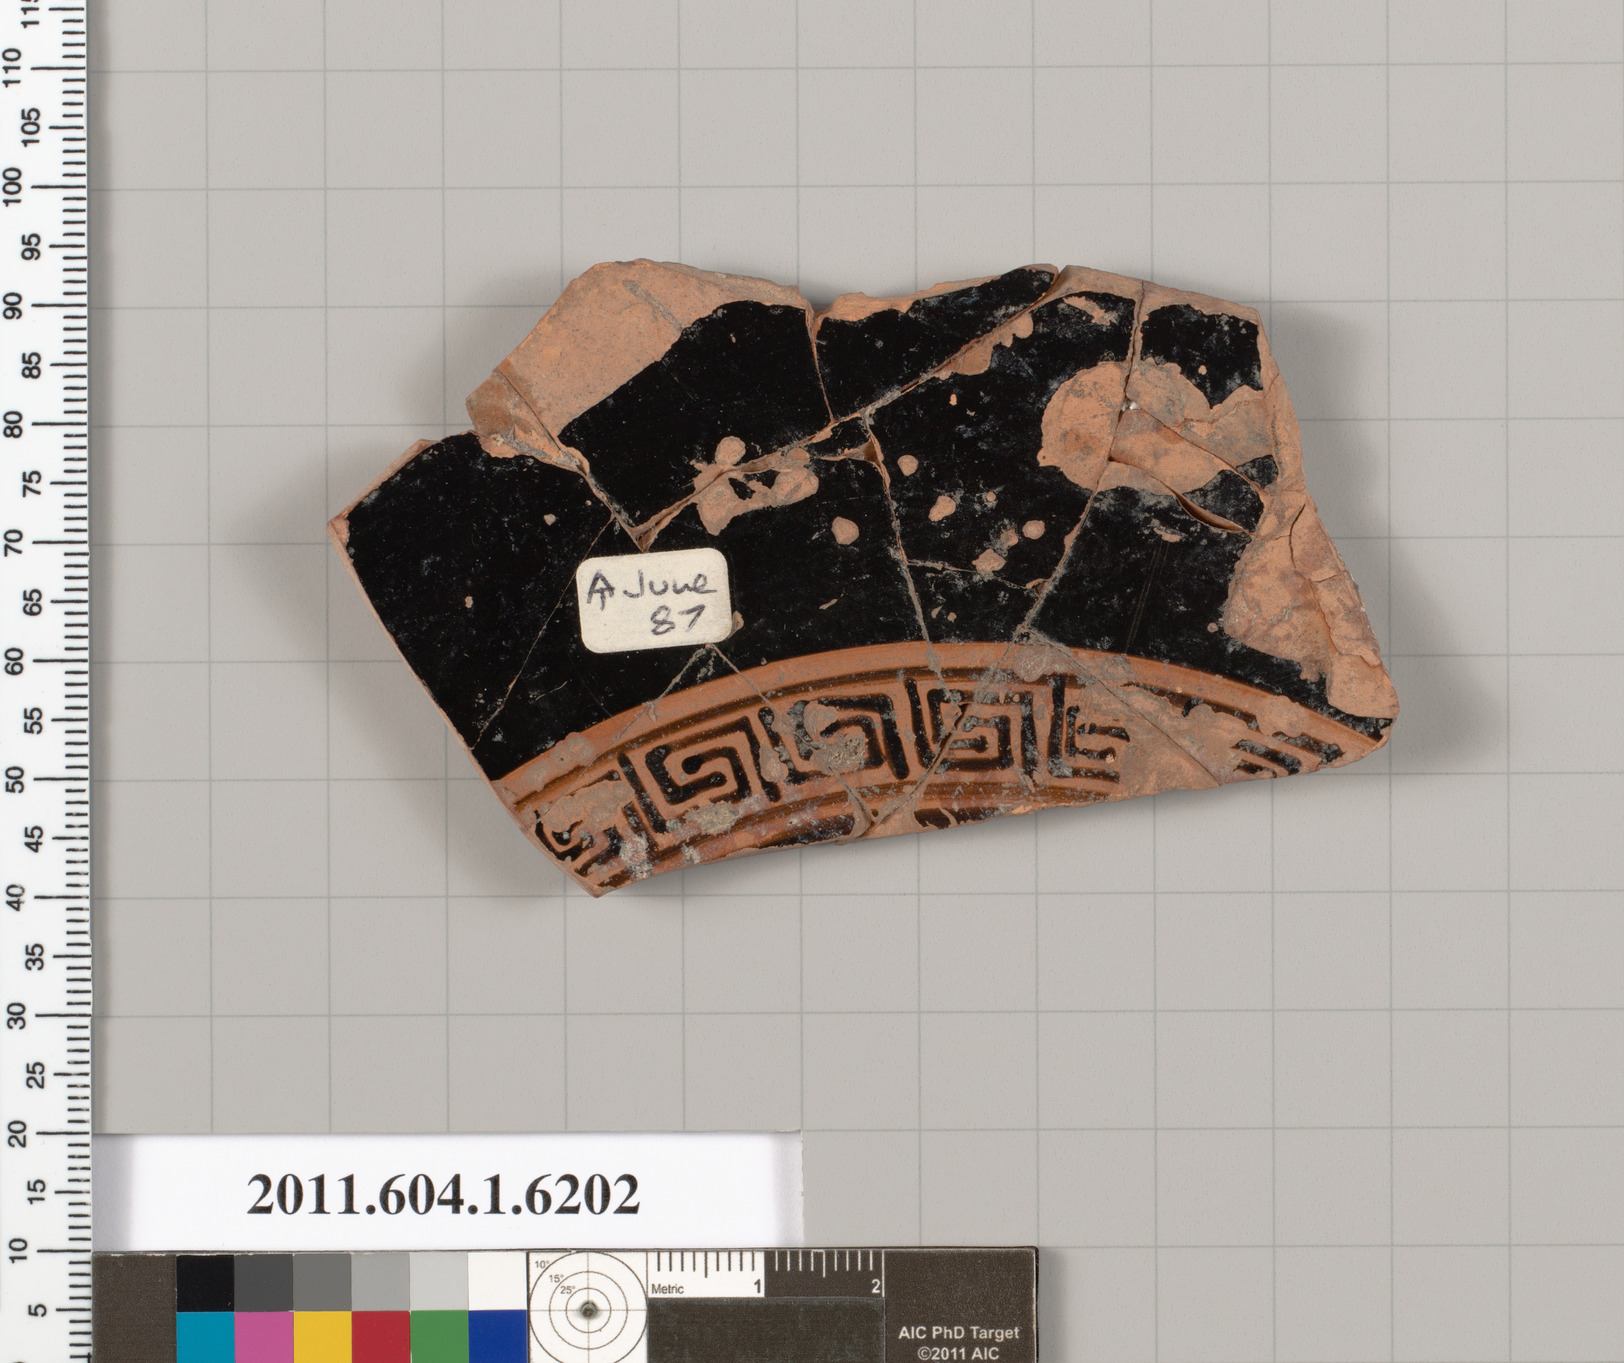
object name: kylix fragment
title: Terracotta fragment of a kylix (drinking cup)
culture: greek, attic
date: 510-500 BCE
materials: terracotta